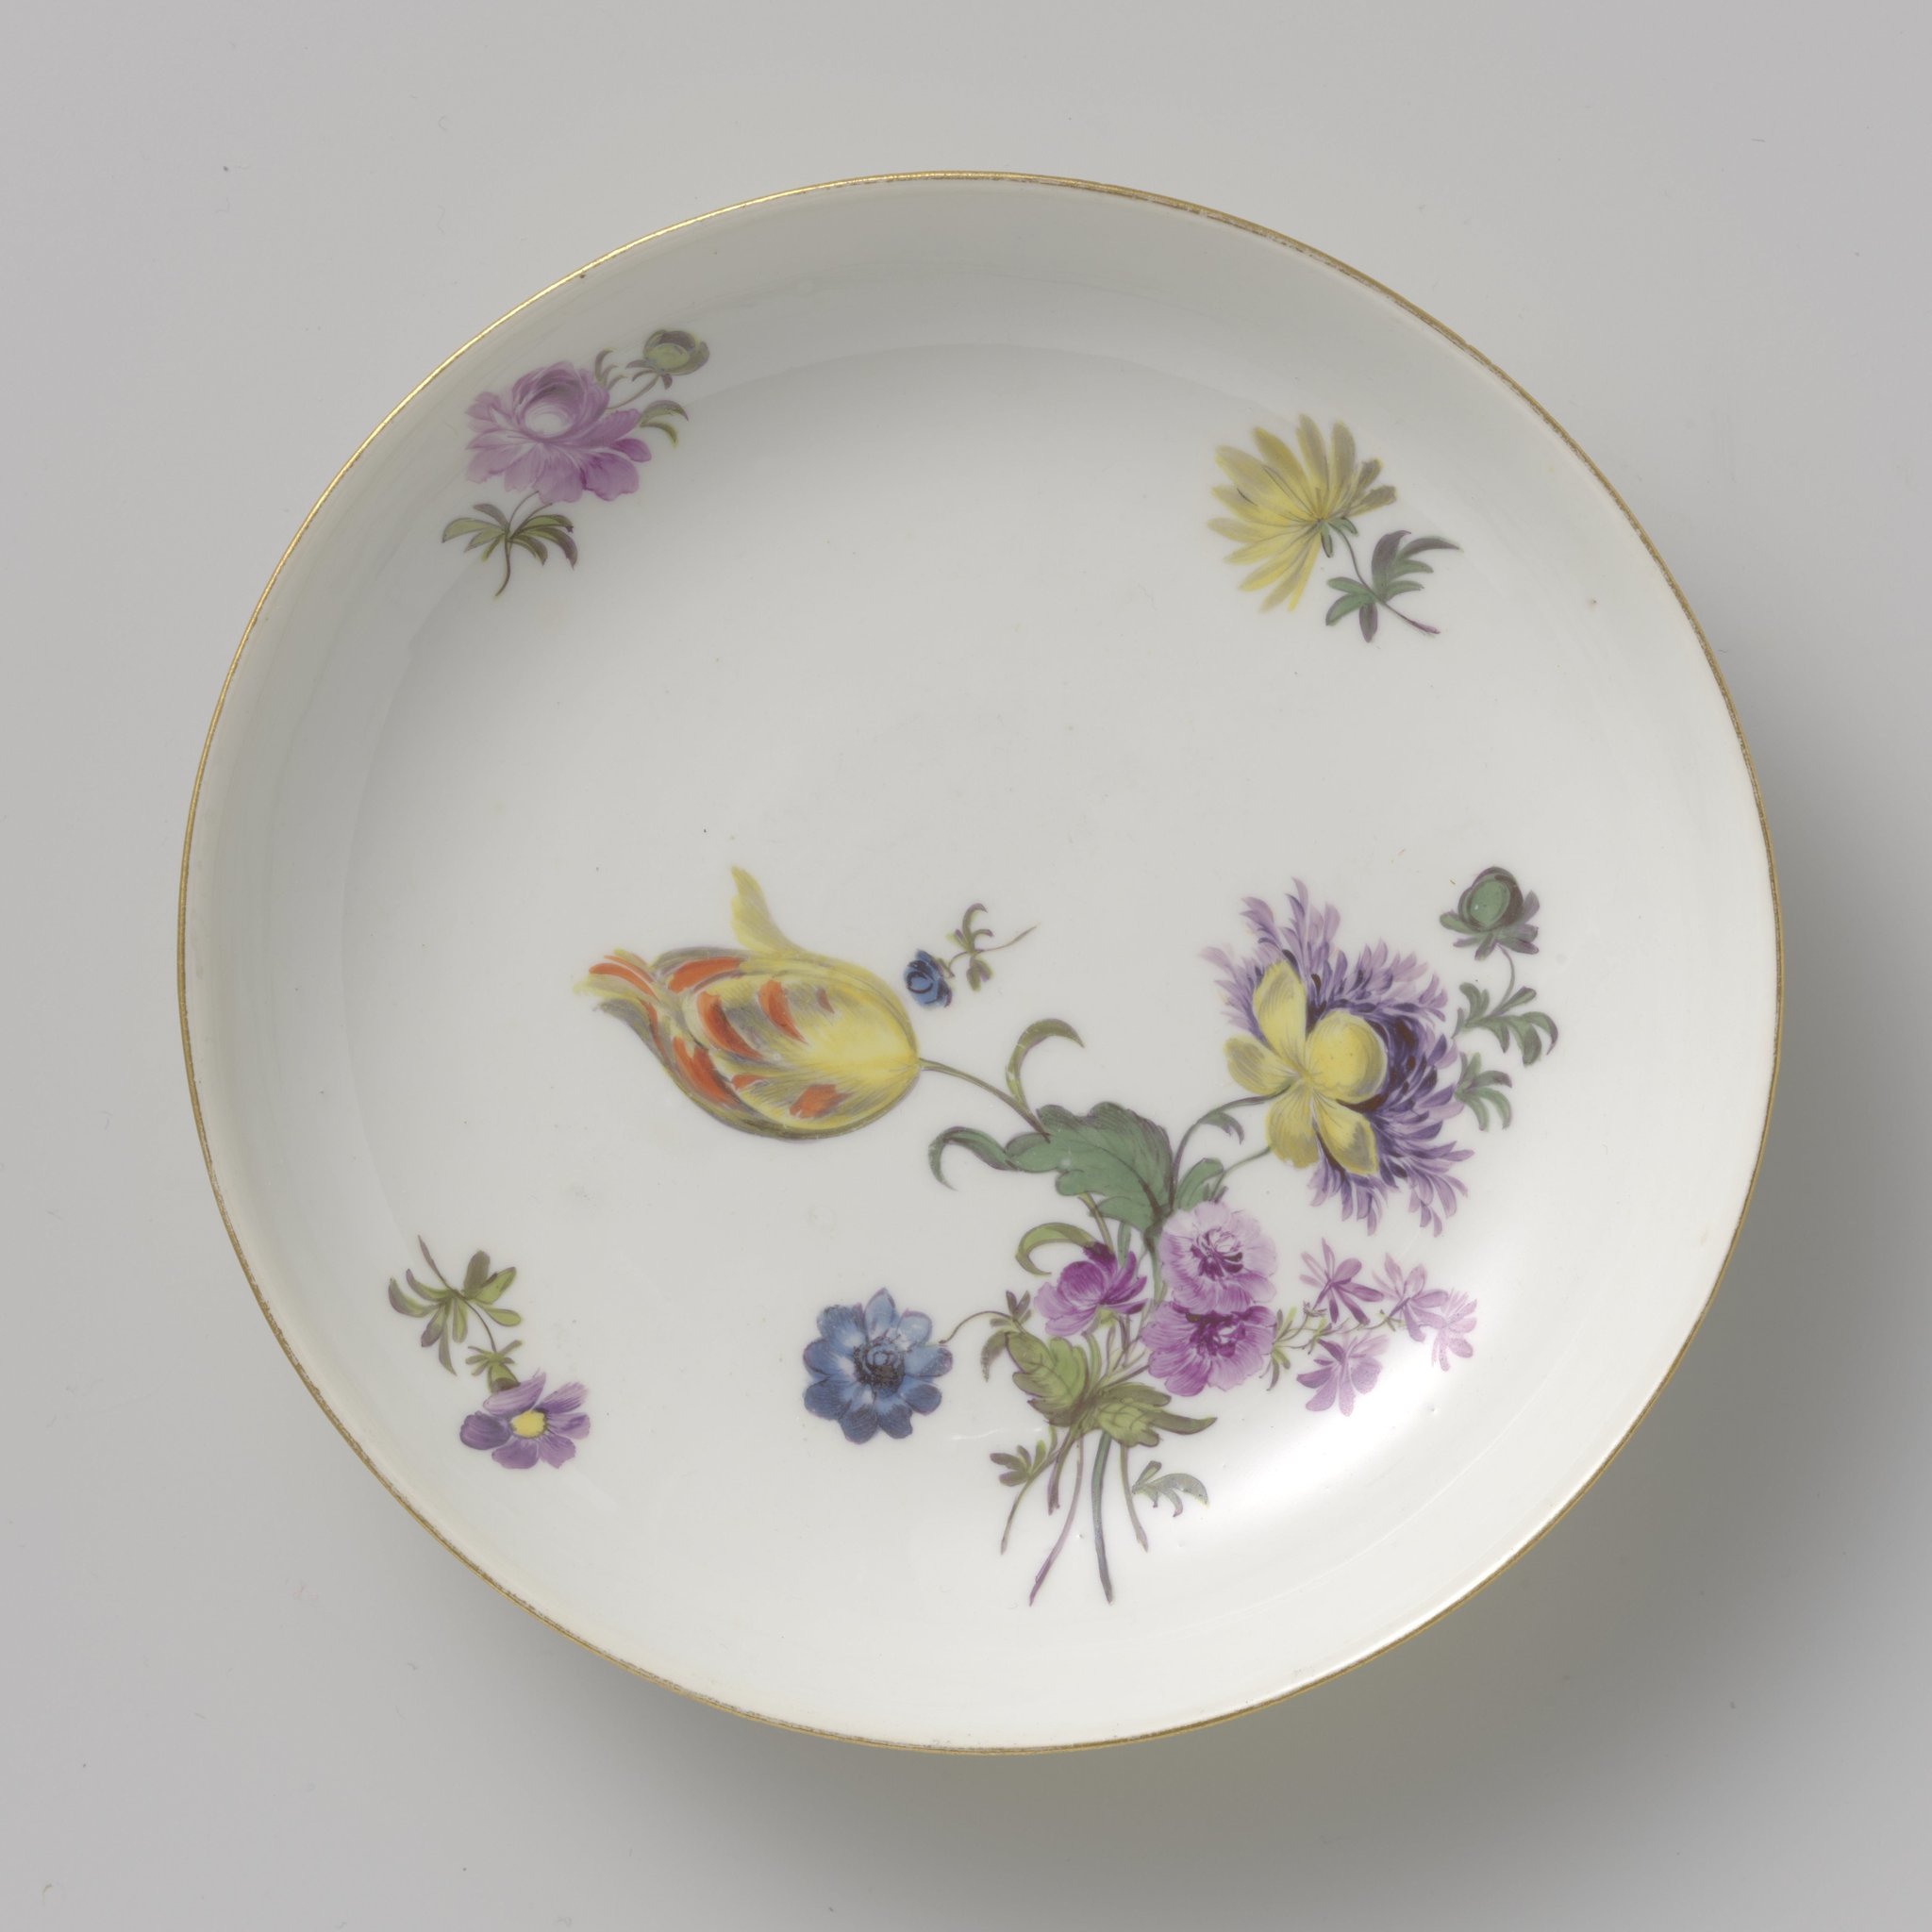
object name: eating drinking utensil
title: Schotel, veelkleurig beschilderd met bloemboeketten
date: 1750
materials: porcelain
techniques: painted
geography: meissen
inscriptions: mold mark: ‘64’, factory mark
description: Ronde schotel van beschilderd porselein. De schotel is beschilderd met bloemboeketten, de achterkant is bedekt met een gele fond. De schotel is gemerkt.